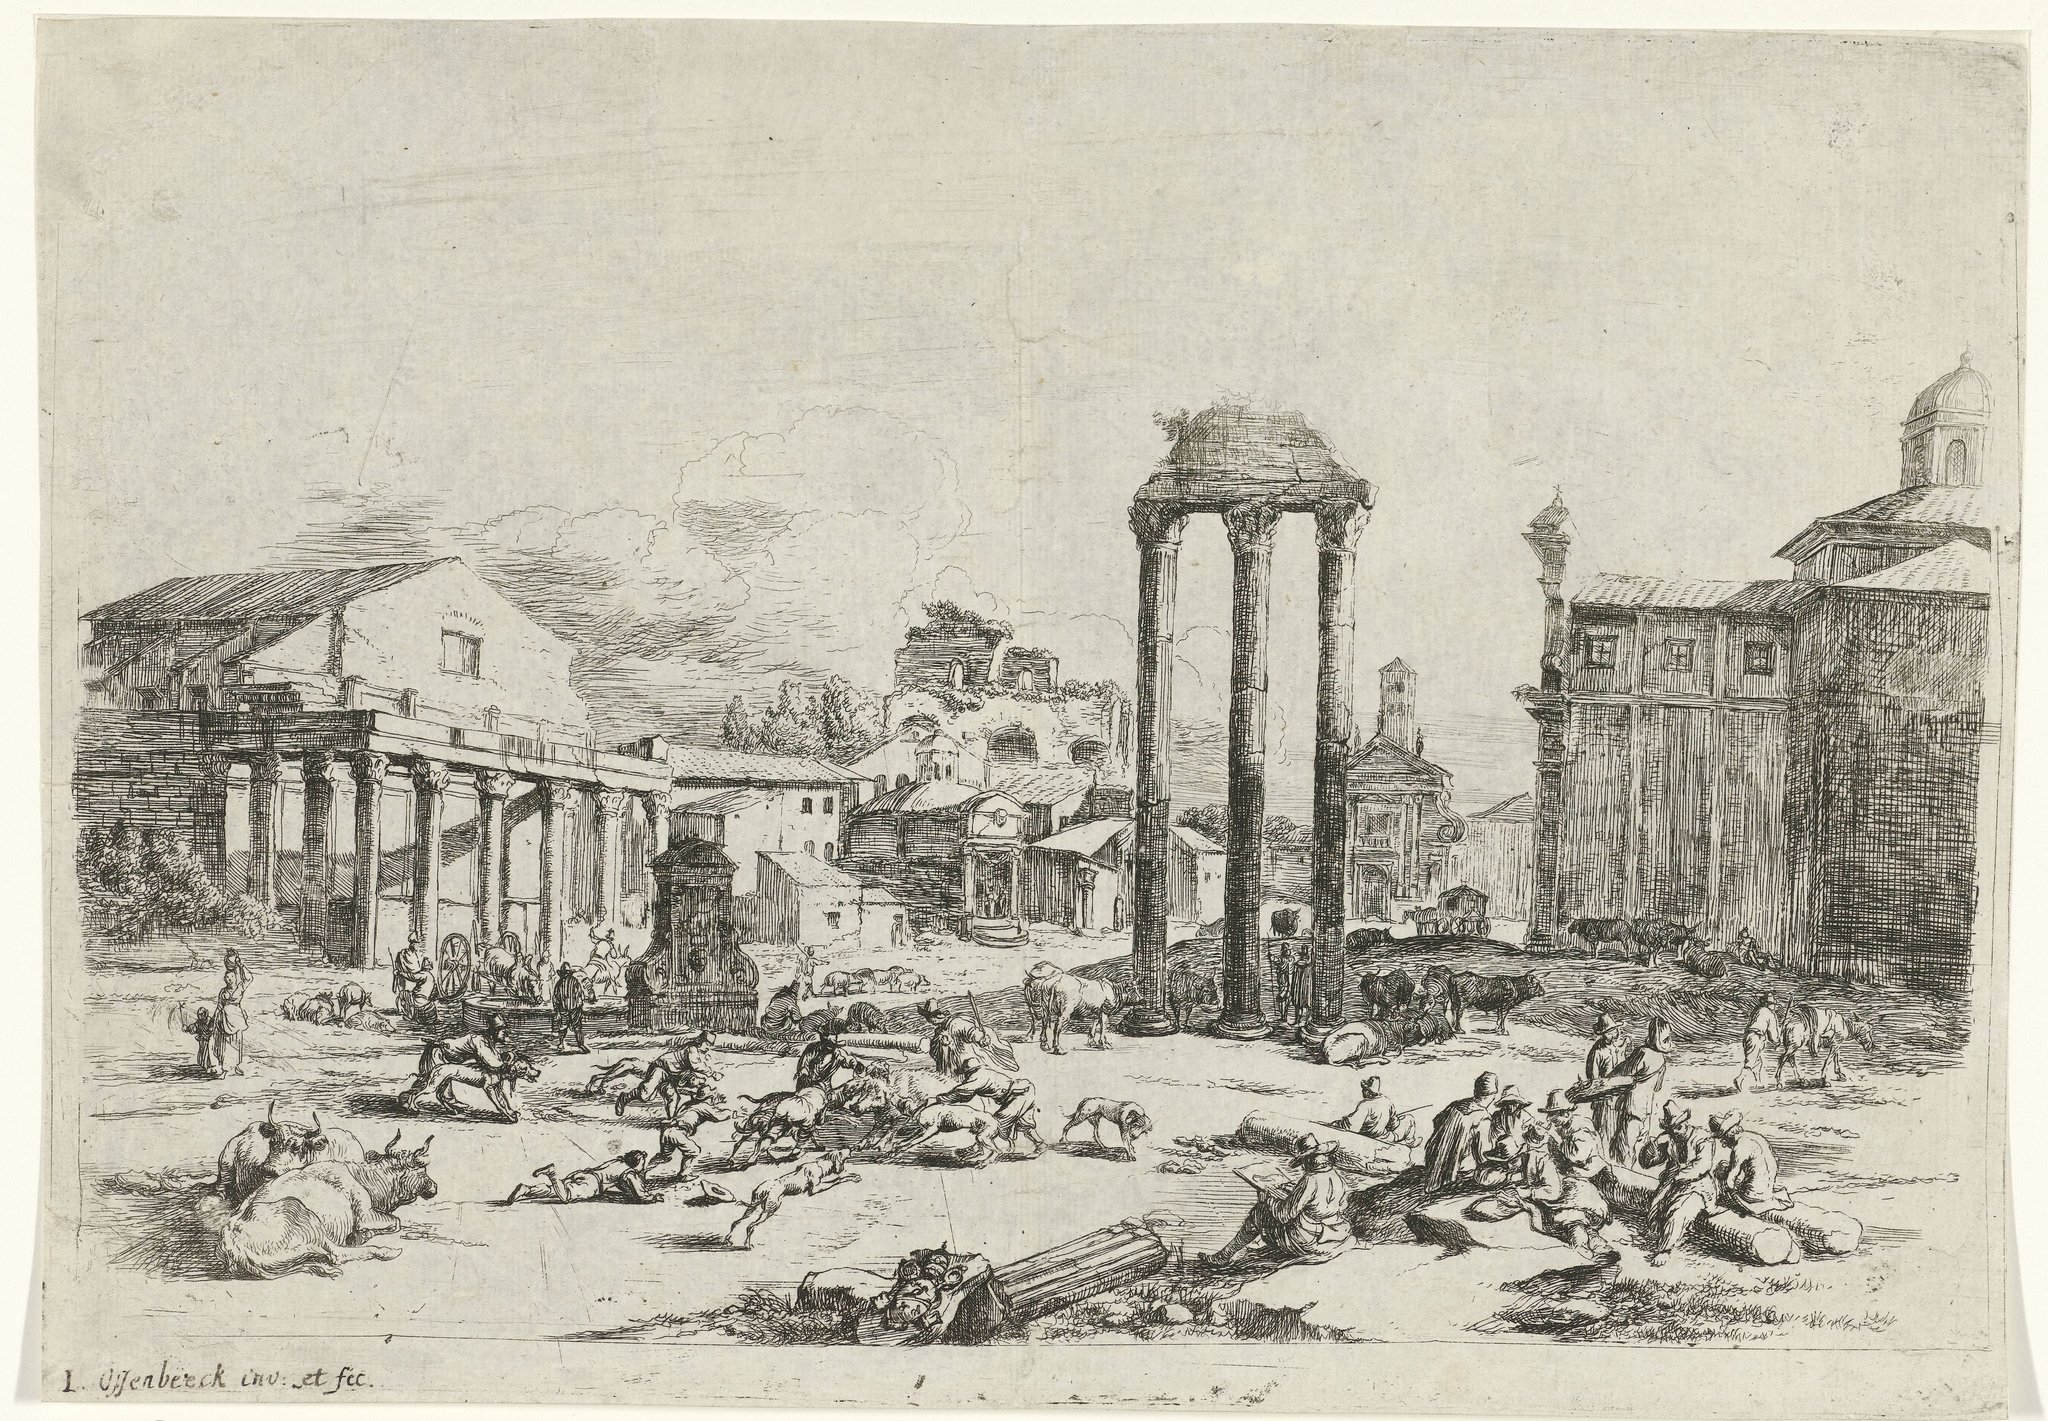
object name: print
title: Veemarkt op de Campo Vaccino te Rome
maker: jan van ossenbeeck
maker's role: print maker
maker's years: 1623-1674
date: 1647-1655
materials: paper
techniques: etching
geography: rome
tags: market, artist (in general) studying classical remains - bb - out of doors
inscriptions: collector's mark: Lugt 2228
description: Veemarkt op de Campo Vaccino op het Forum Romanum. De koeien lopen tussen de ruïnes van de tempel van Jupiter. Rechts op de voorgrond een tekenaar die de ruïnes vastlegt.